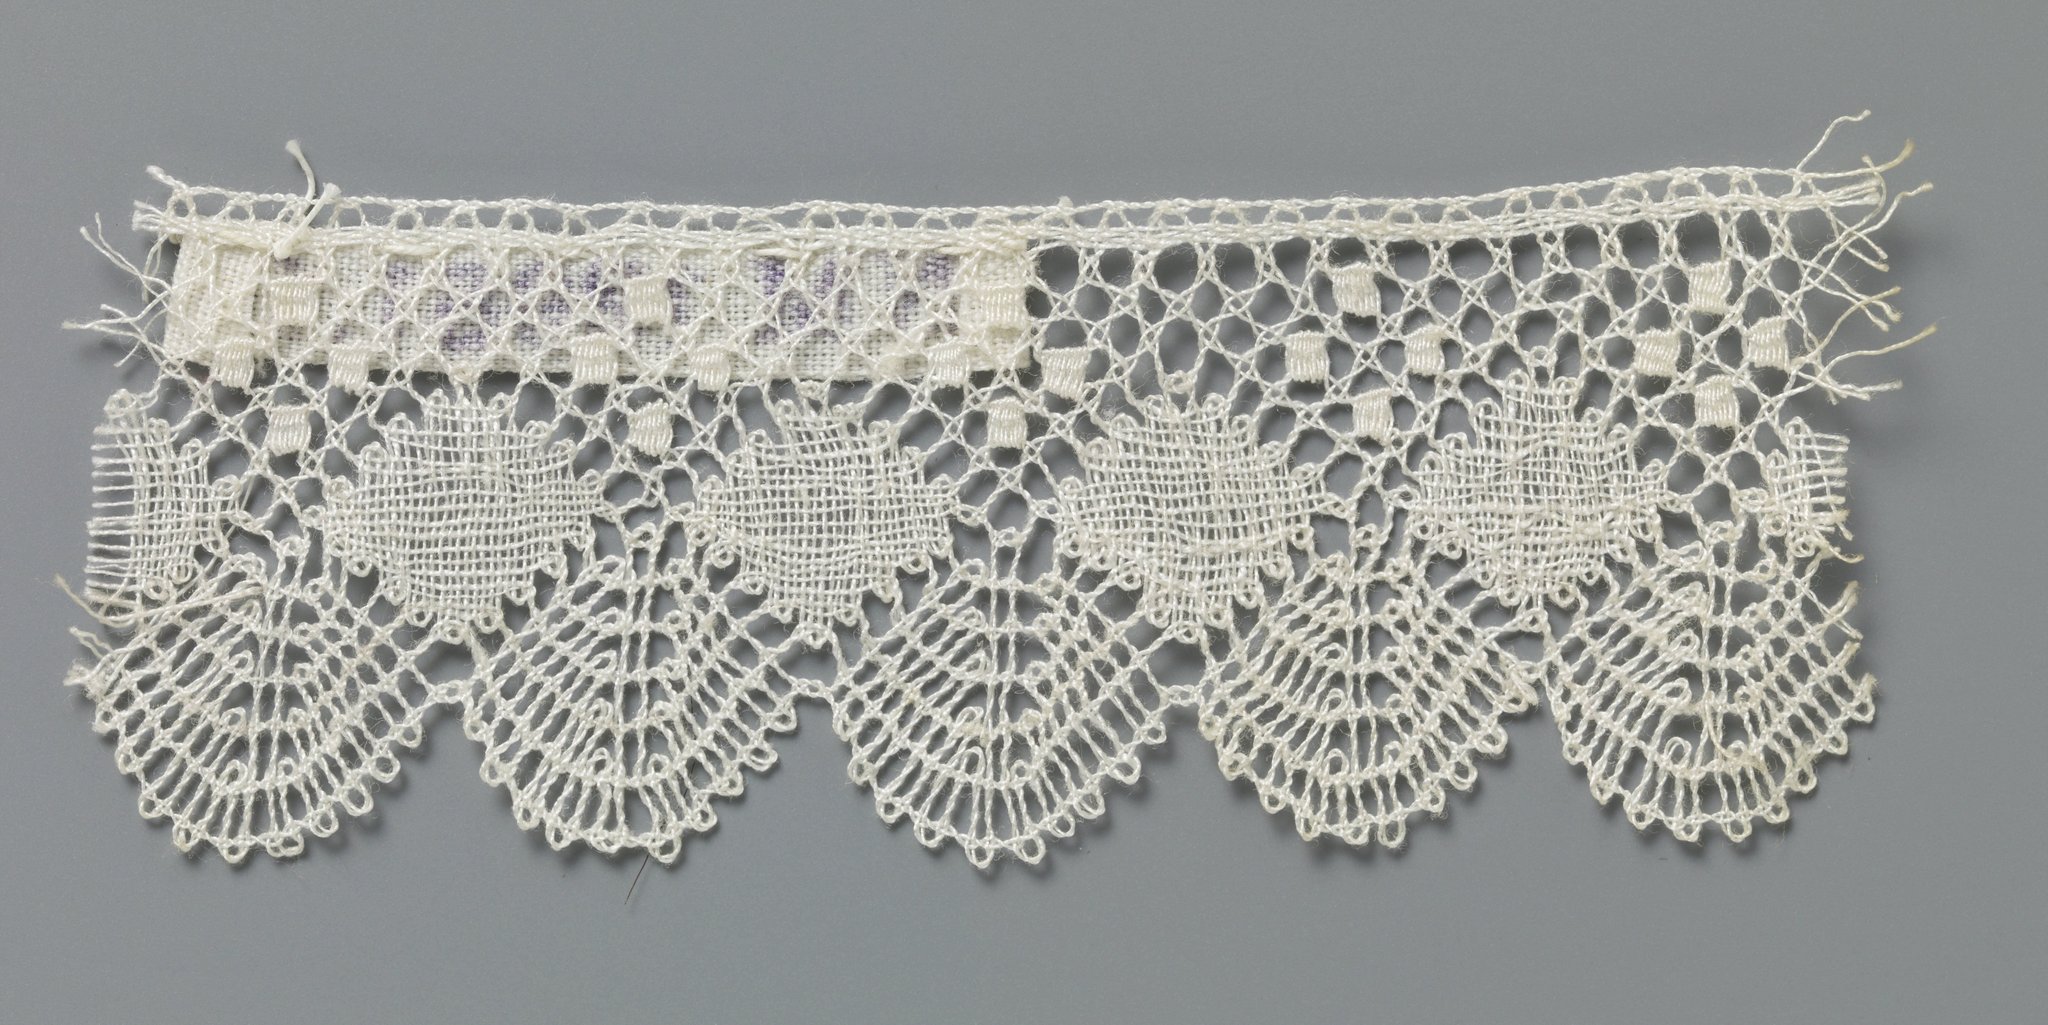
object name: strip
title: Strook kloskant met ruiten tussen waaiervormige schulpen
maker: Anonymous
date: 1800-1899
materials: linen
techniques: lace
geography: buckingham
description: Strook naturelkleurige kloskant, stropkant. Het zich herhalende patroon bestaat langs de onderzijde van de strook uit tegen elkaar aan geplaatste waaiervormige schulpen. Boven de schulpenrand is in de ruimte tussen de waaiers steeds één ruit geplaatst. De ruiten zijn gemaakt in linnenslag en zijn aan de bovenzijde van de strook met elkaar verbonden door een traliegrond: een stroptraliegrond. De grond is versierd met vierkante moesjes, gemaakt in vormslag. Er staan steeds vier moesjes in ruitvormige configuratie tussen de ruiten in. De bovenzijde van de strook is recht afgewerkt.